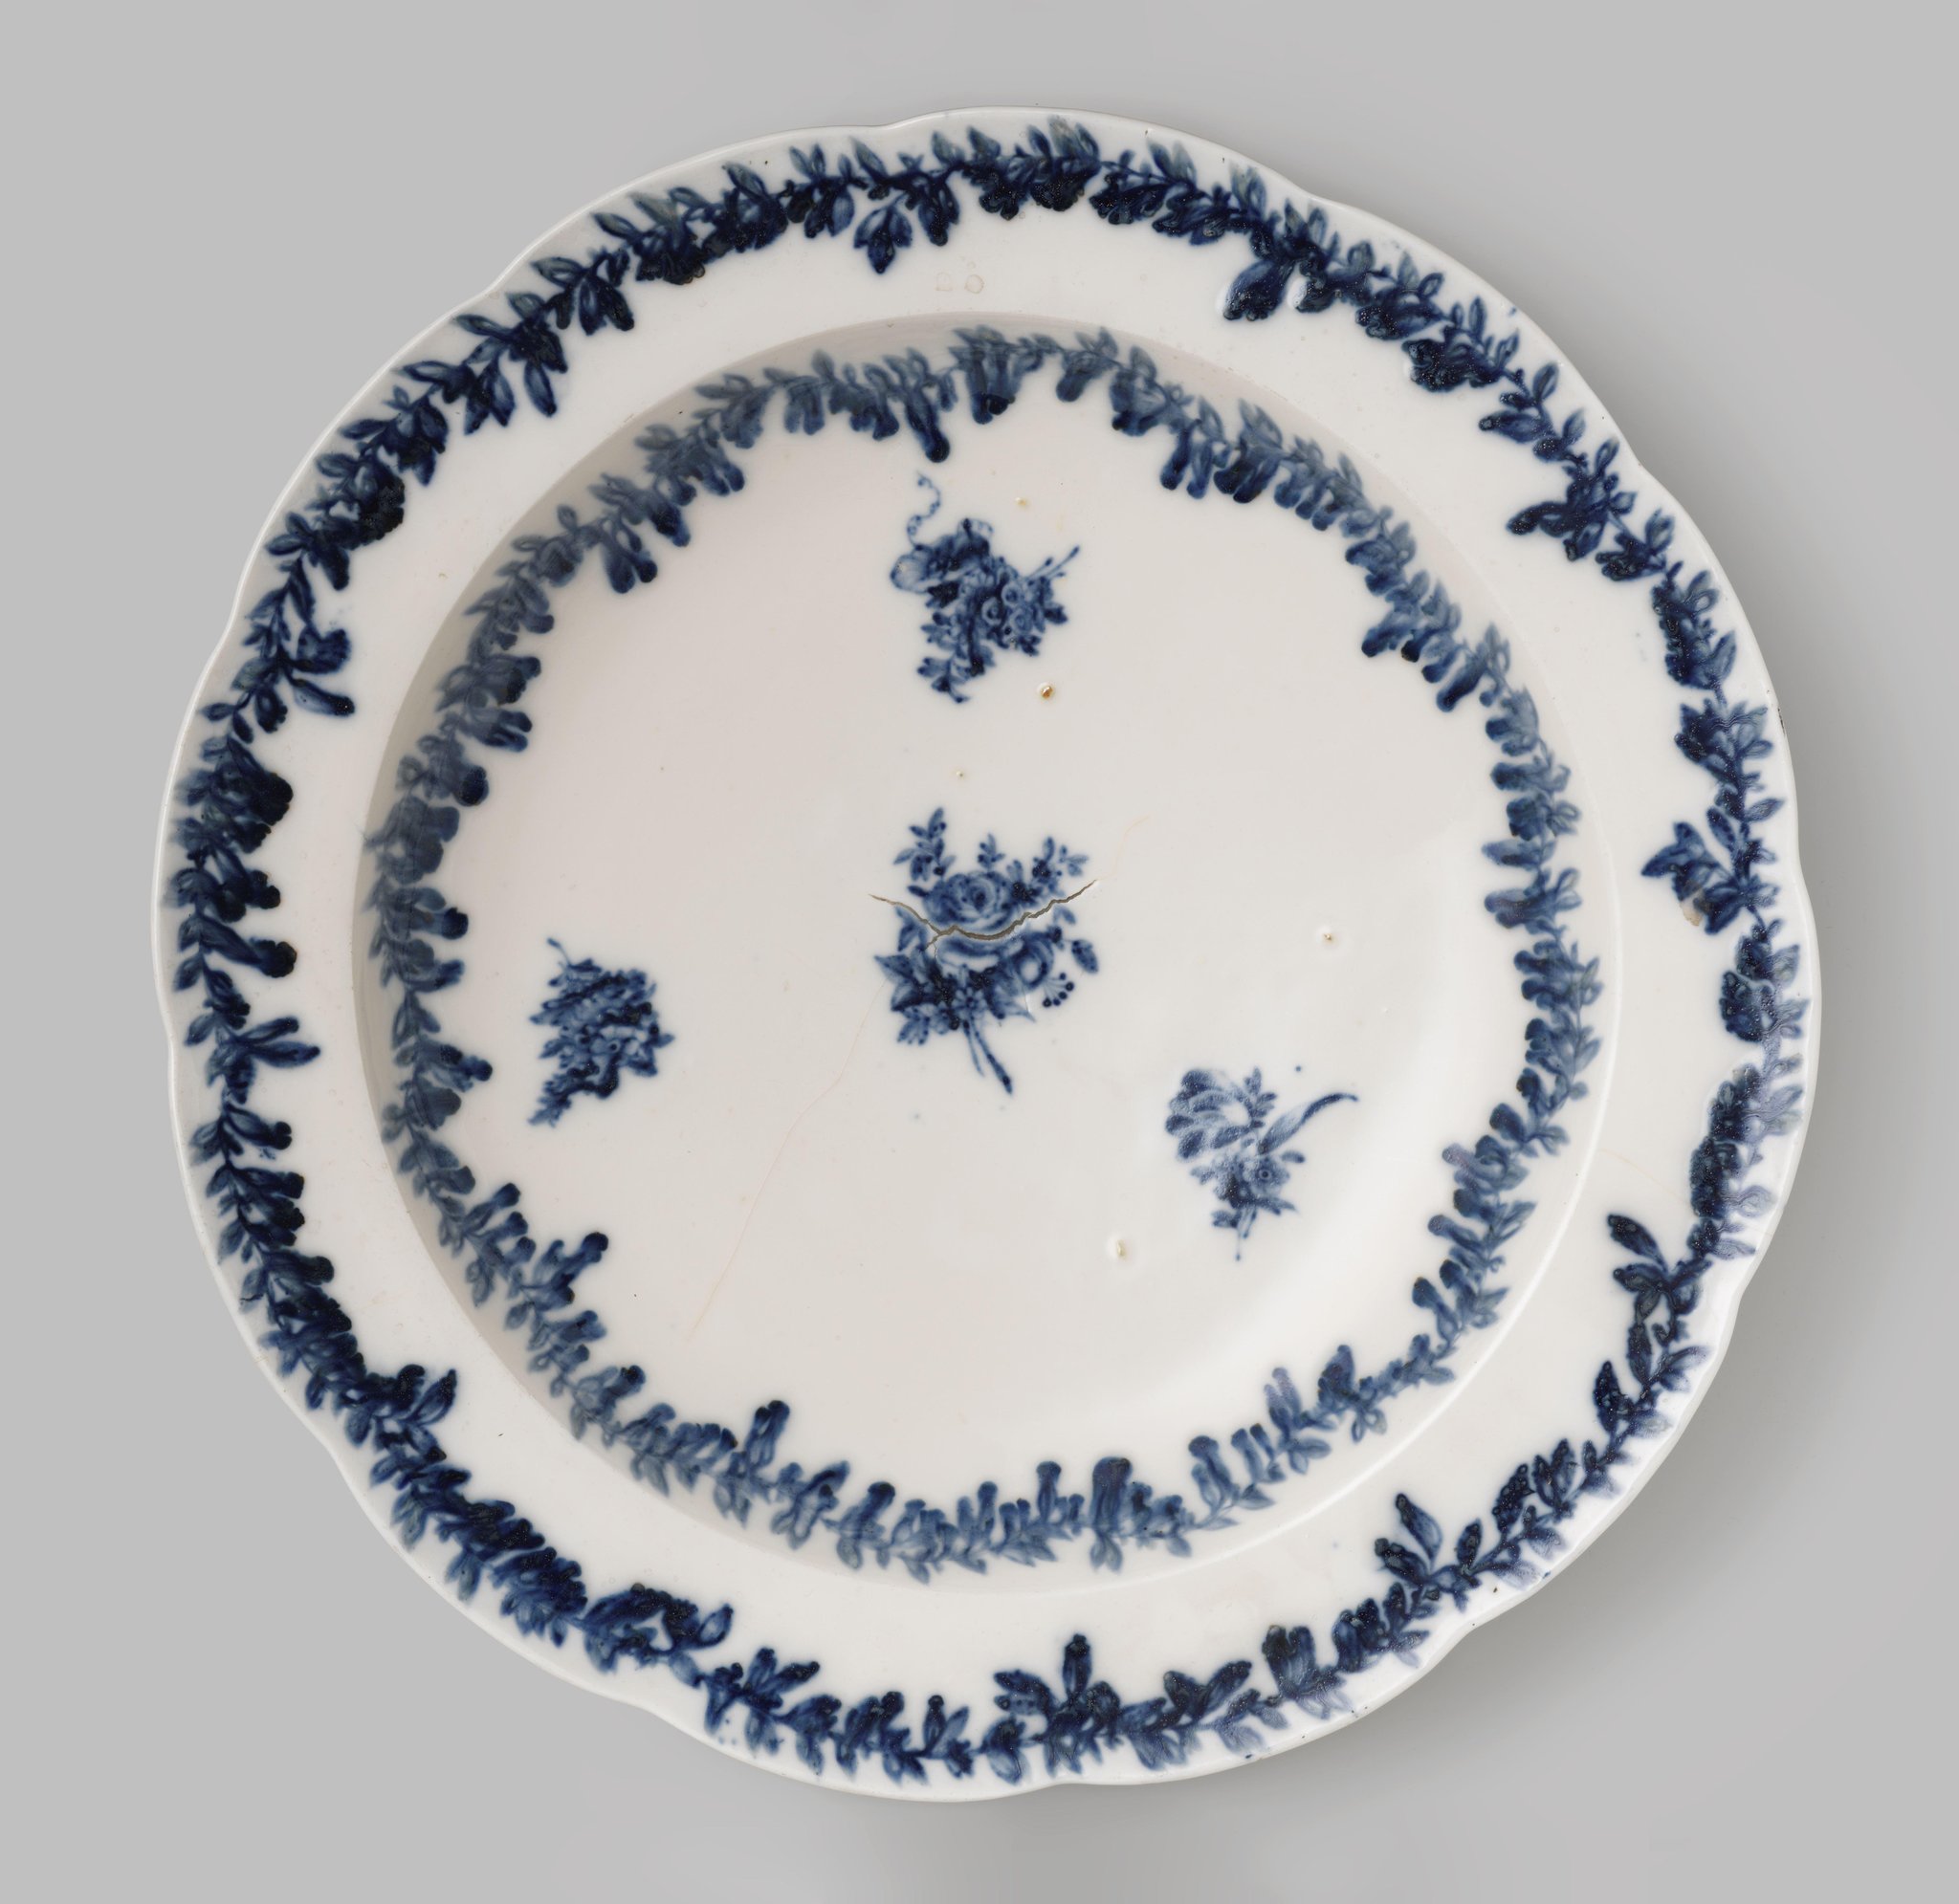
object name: platter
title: Schotel van porselein met strooibloemen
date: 1774-1784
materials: porcelain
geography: loosdrecht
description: Schotel van porselein. Op het plat beschilderd in blauw met strooibloemen en bloemranden.